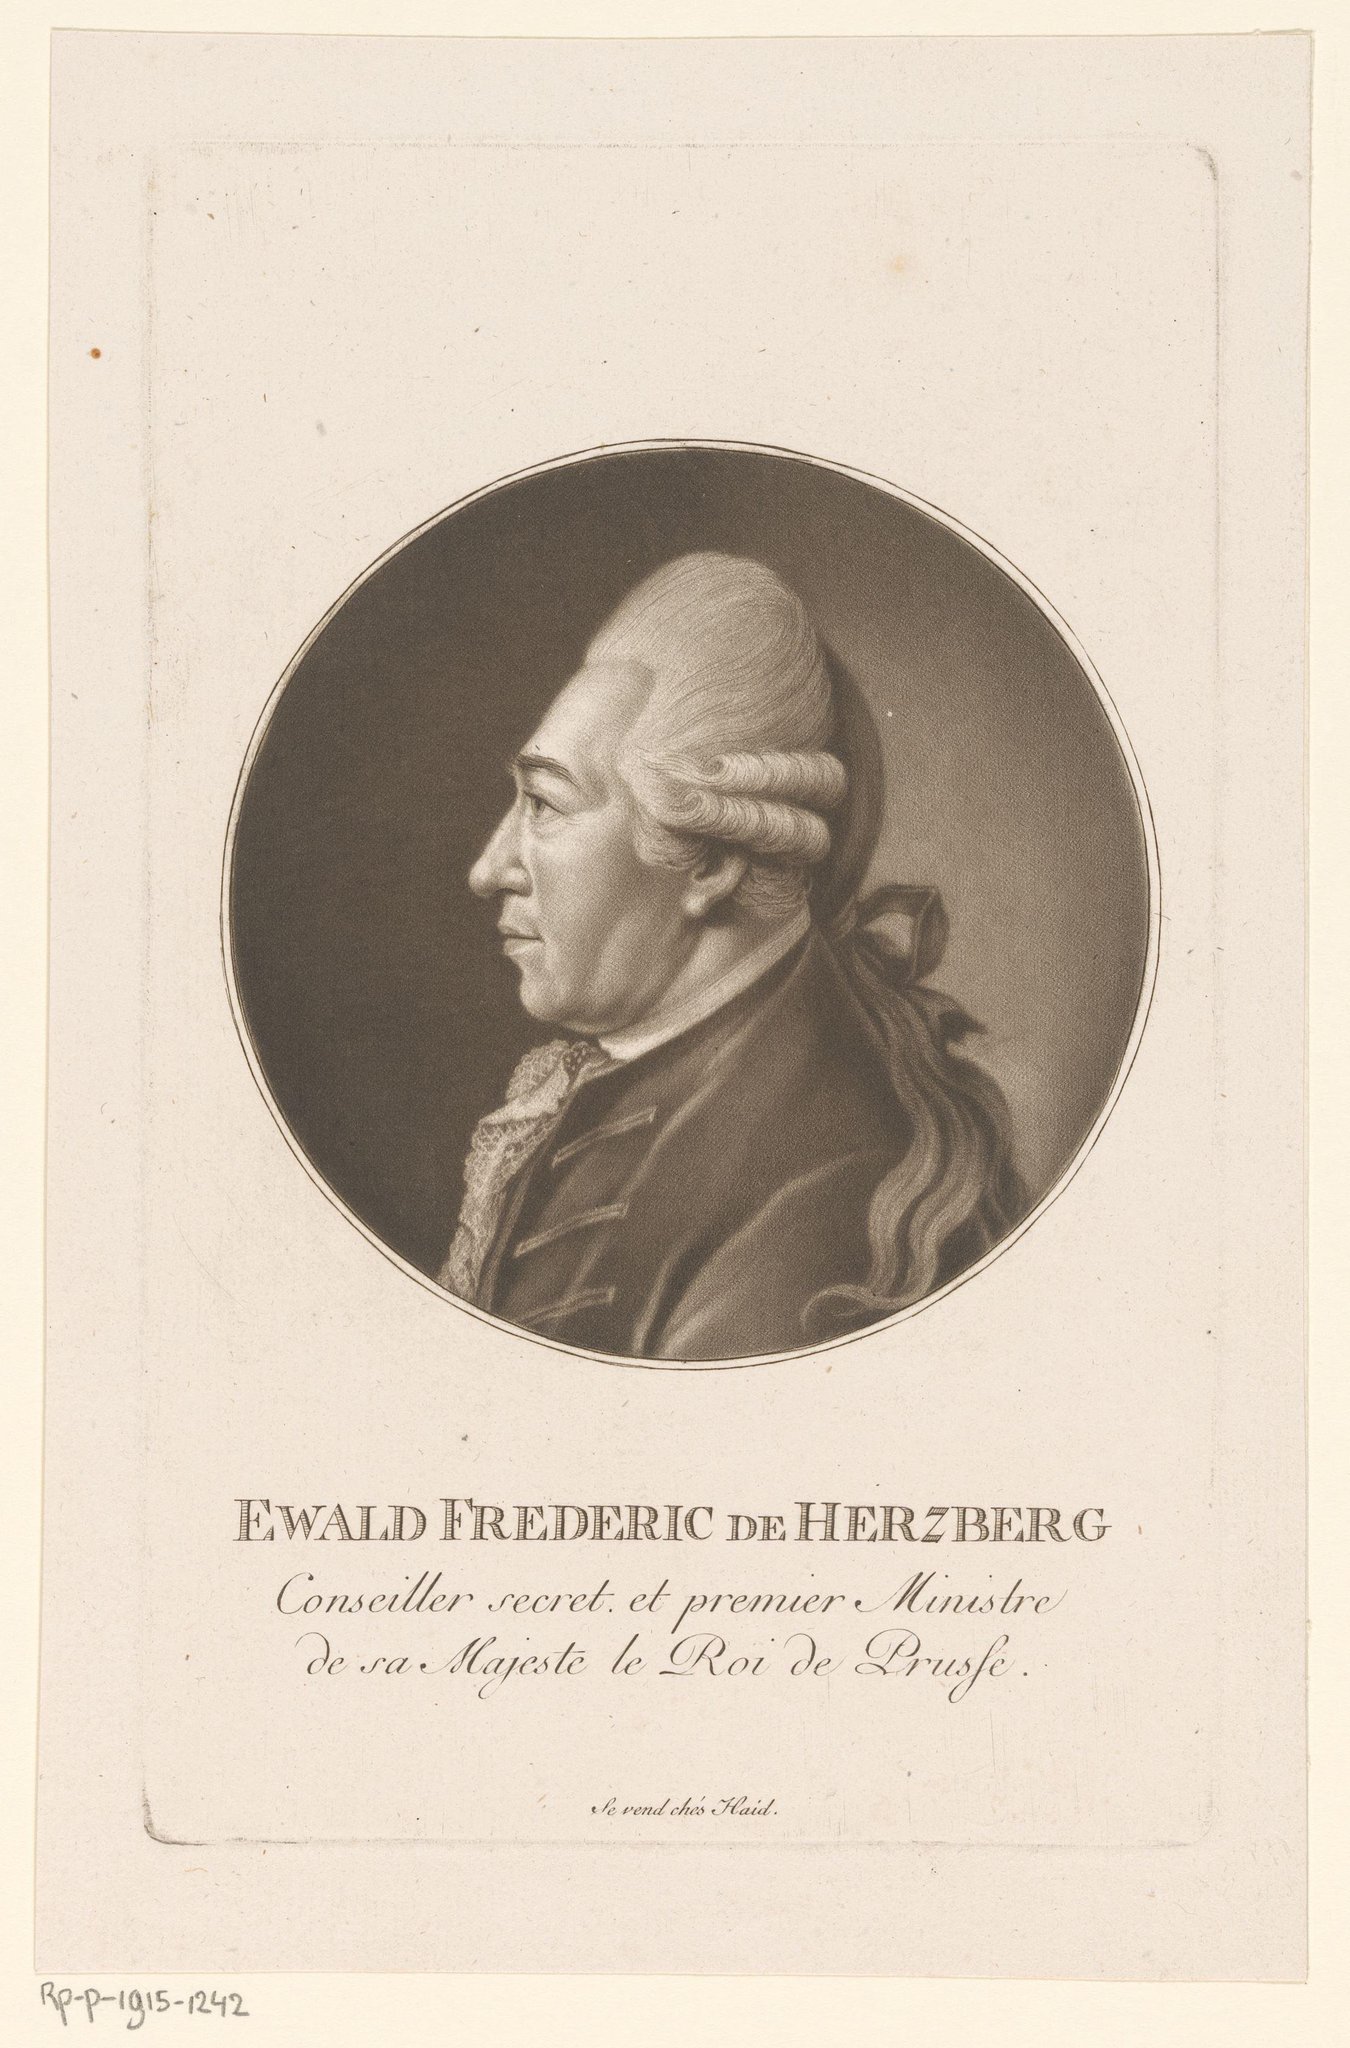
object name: print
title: Portret van Ewald Friedrich von Hertzberg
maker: johann elias haid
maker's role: print maker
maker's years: 1739-1809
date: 1749-1795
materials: paper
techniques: mezzotint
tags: poland, berlin, ewald friedrich von hertzberg (graaf), minister ~ government, historical persons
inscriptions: collector's mark: Lugt 2228